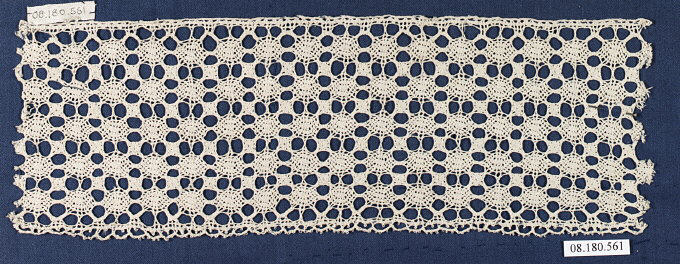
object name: piece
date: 1701-1800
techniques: lace